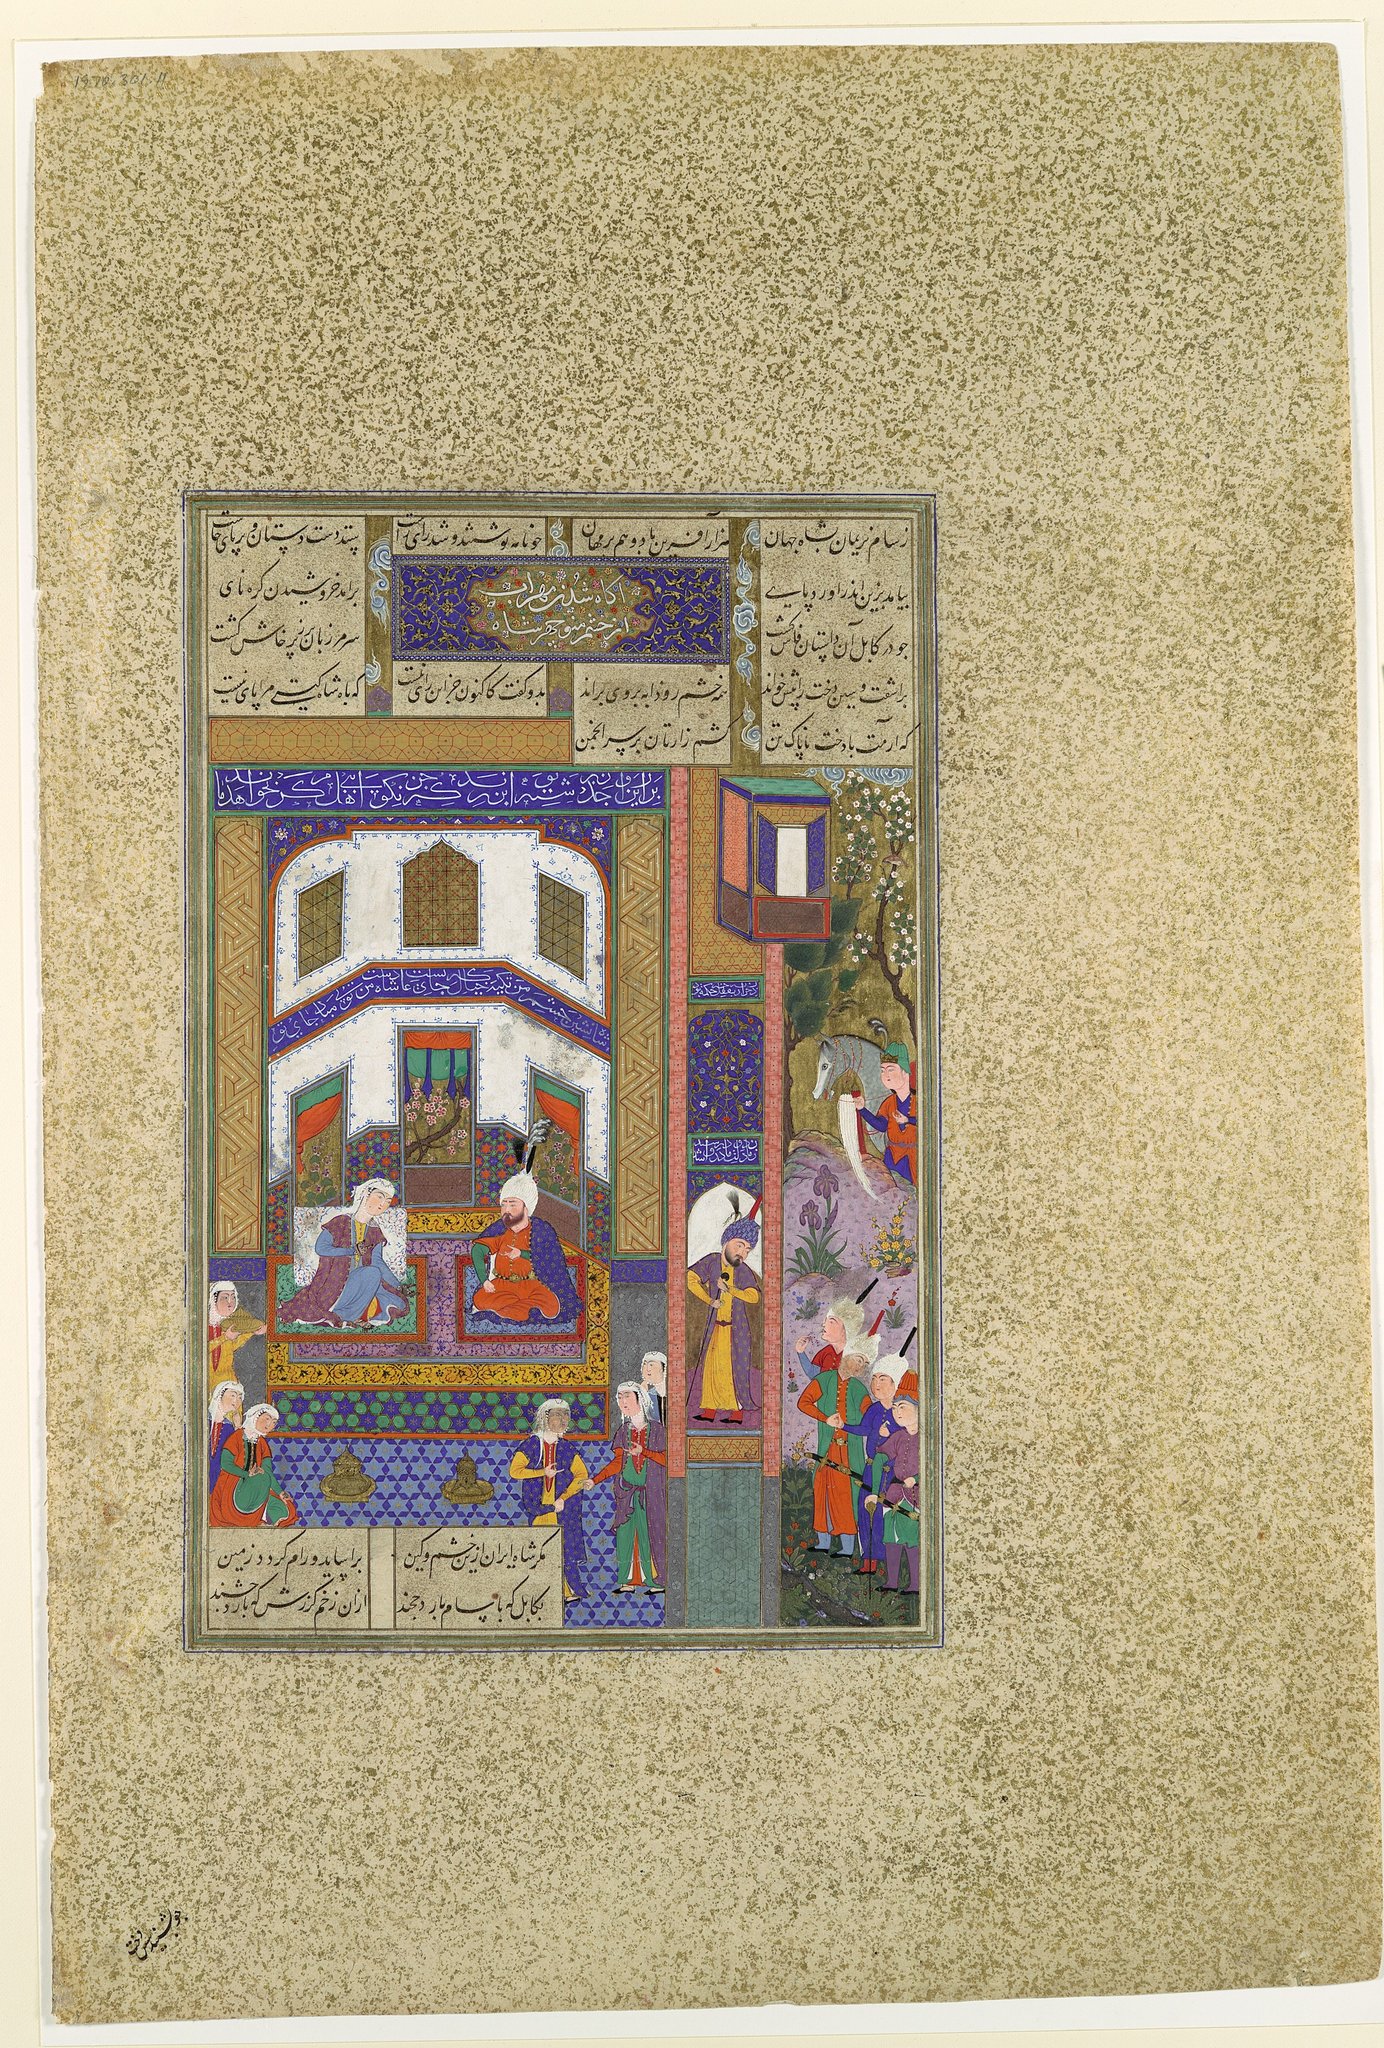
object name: folio from an illustrated manuscript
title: "Mihrab Vents His Anger Upon Sindukht", Folio 83v from the Shahnama (Book of Kings) of Shah Tahmasp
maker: abu'l qasim firdausi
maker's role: author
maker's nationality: iranian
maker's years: 935-1020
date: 1525-1530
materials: gold, ink, paper, silver, watercolor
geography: iran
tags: men,women,horses